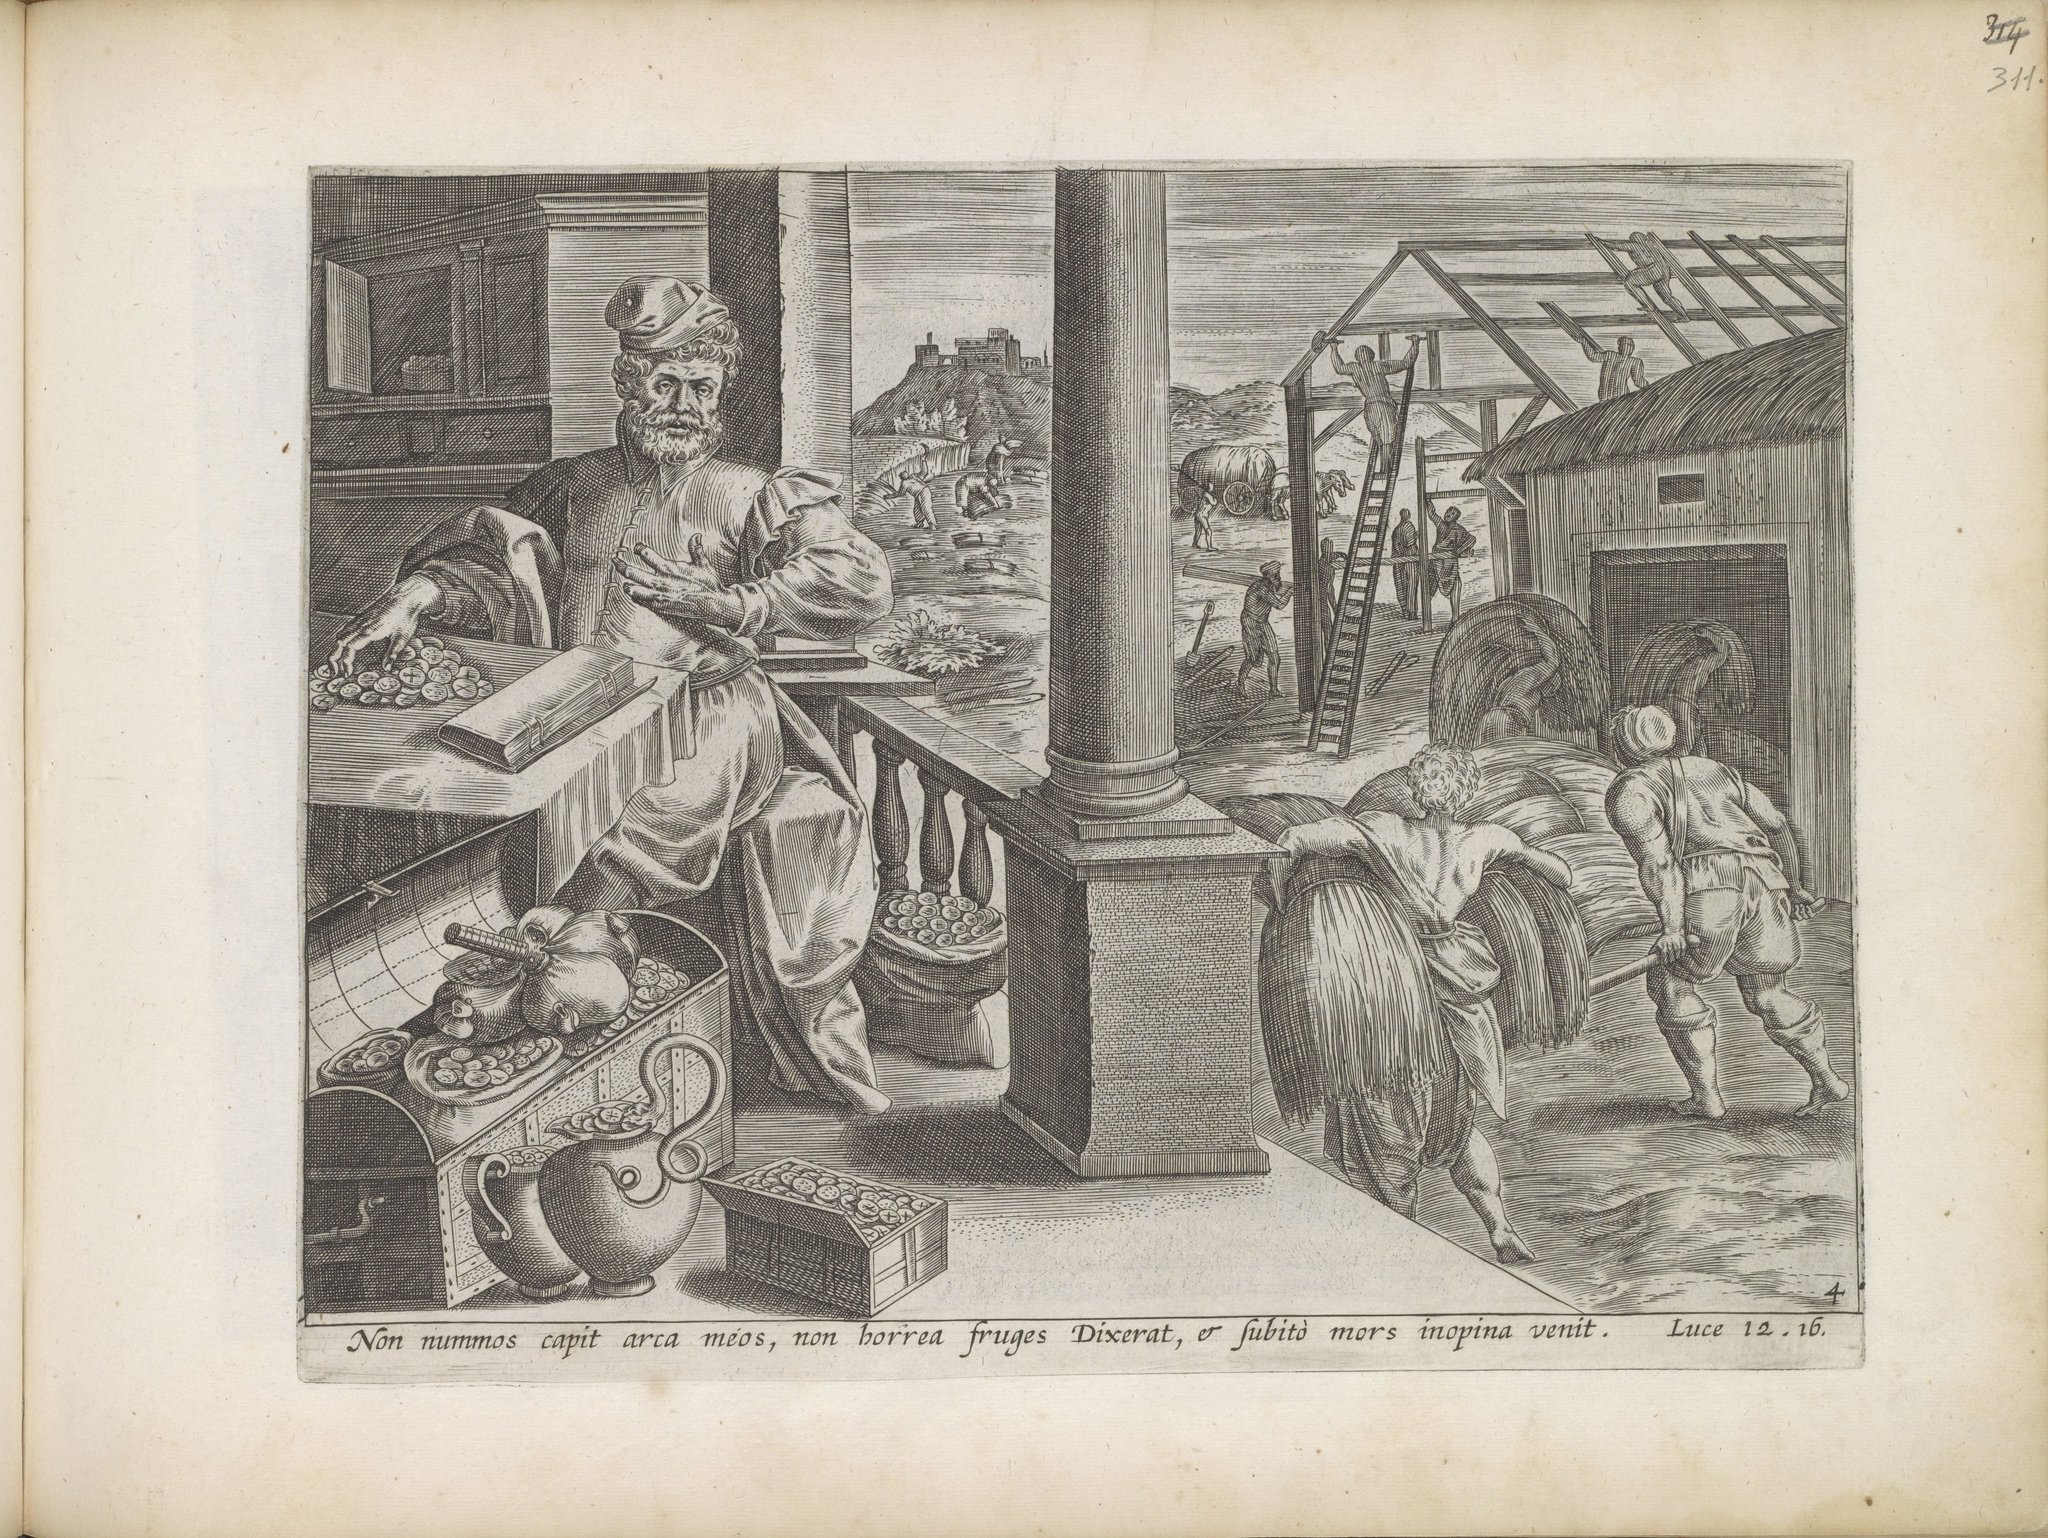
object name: print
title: Gelijkenissen uit het Nieuwe Testament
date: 1585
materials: paper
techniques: engraving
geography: amsterdam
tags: purse, money-bag, the rich fool, whose death comes when he has saved all his money to build new barns (luke 12:16-21)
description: Een rijke man laat nog grotere schuren bouwen voor zijn rijkdommen en zijn graan. Hij zit aan tafel tussen zijn geld. In de geopende kist ligt een stokbeurs. Onder de voorstelling een verwijzing in het Latijn naar de Bijbeltekst in Luc. 12:16 en naar het vervolg van het verhaal: de rijke man zal 's nachts sterven. Deze prent maakt deel uit van een album.